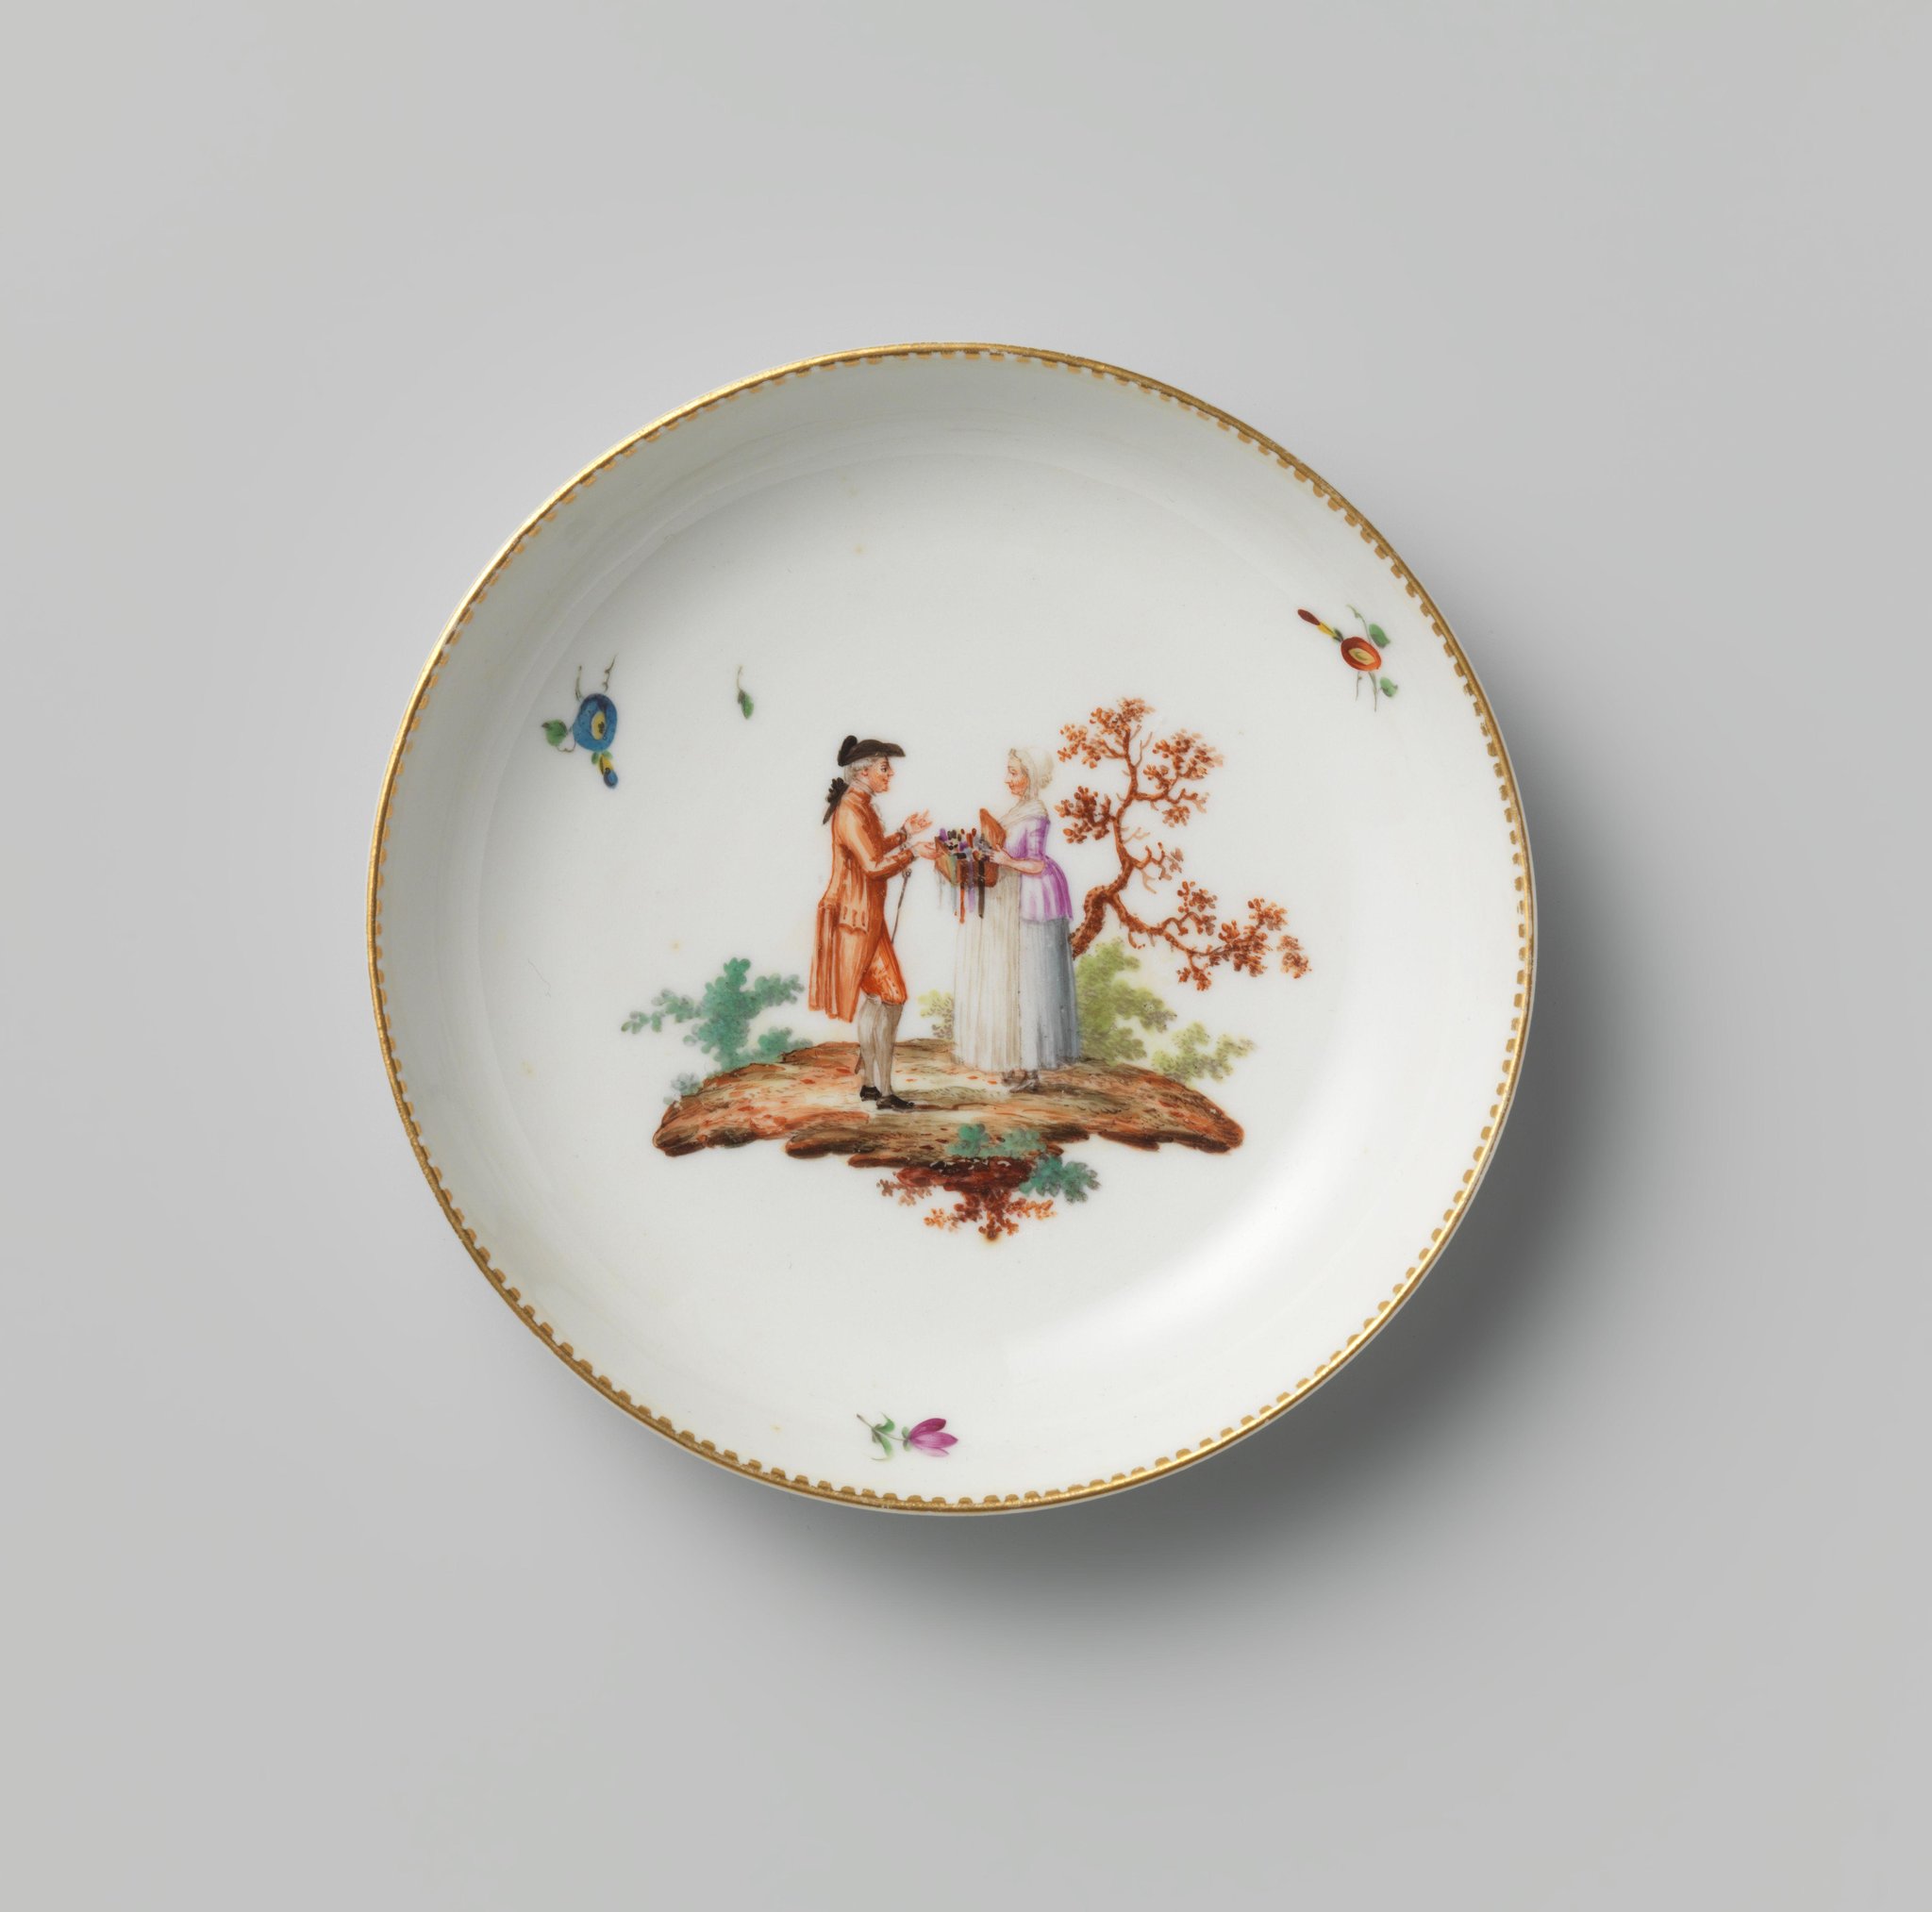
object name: platter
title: Schotel, beschilderd met een heer en een koopvrouw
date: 1782-1784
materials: porcelain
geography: loosdrecht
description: Cup and saucer. Porcelain. Loosdrecht, c. 1780 - 1784.